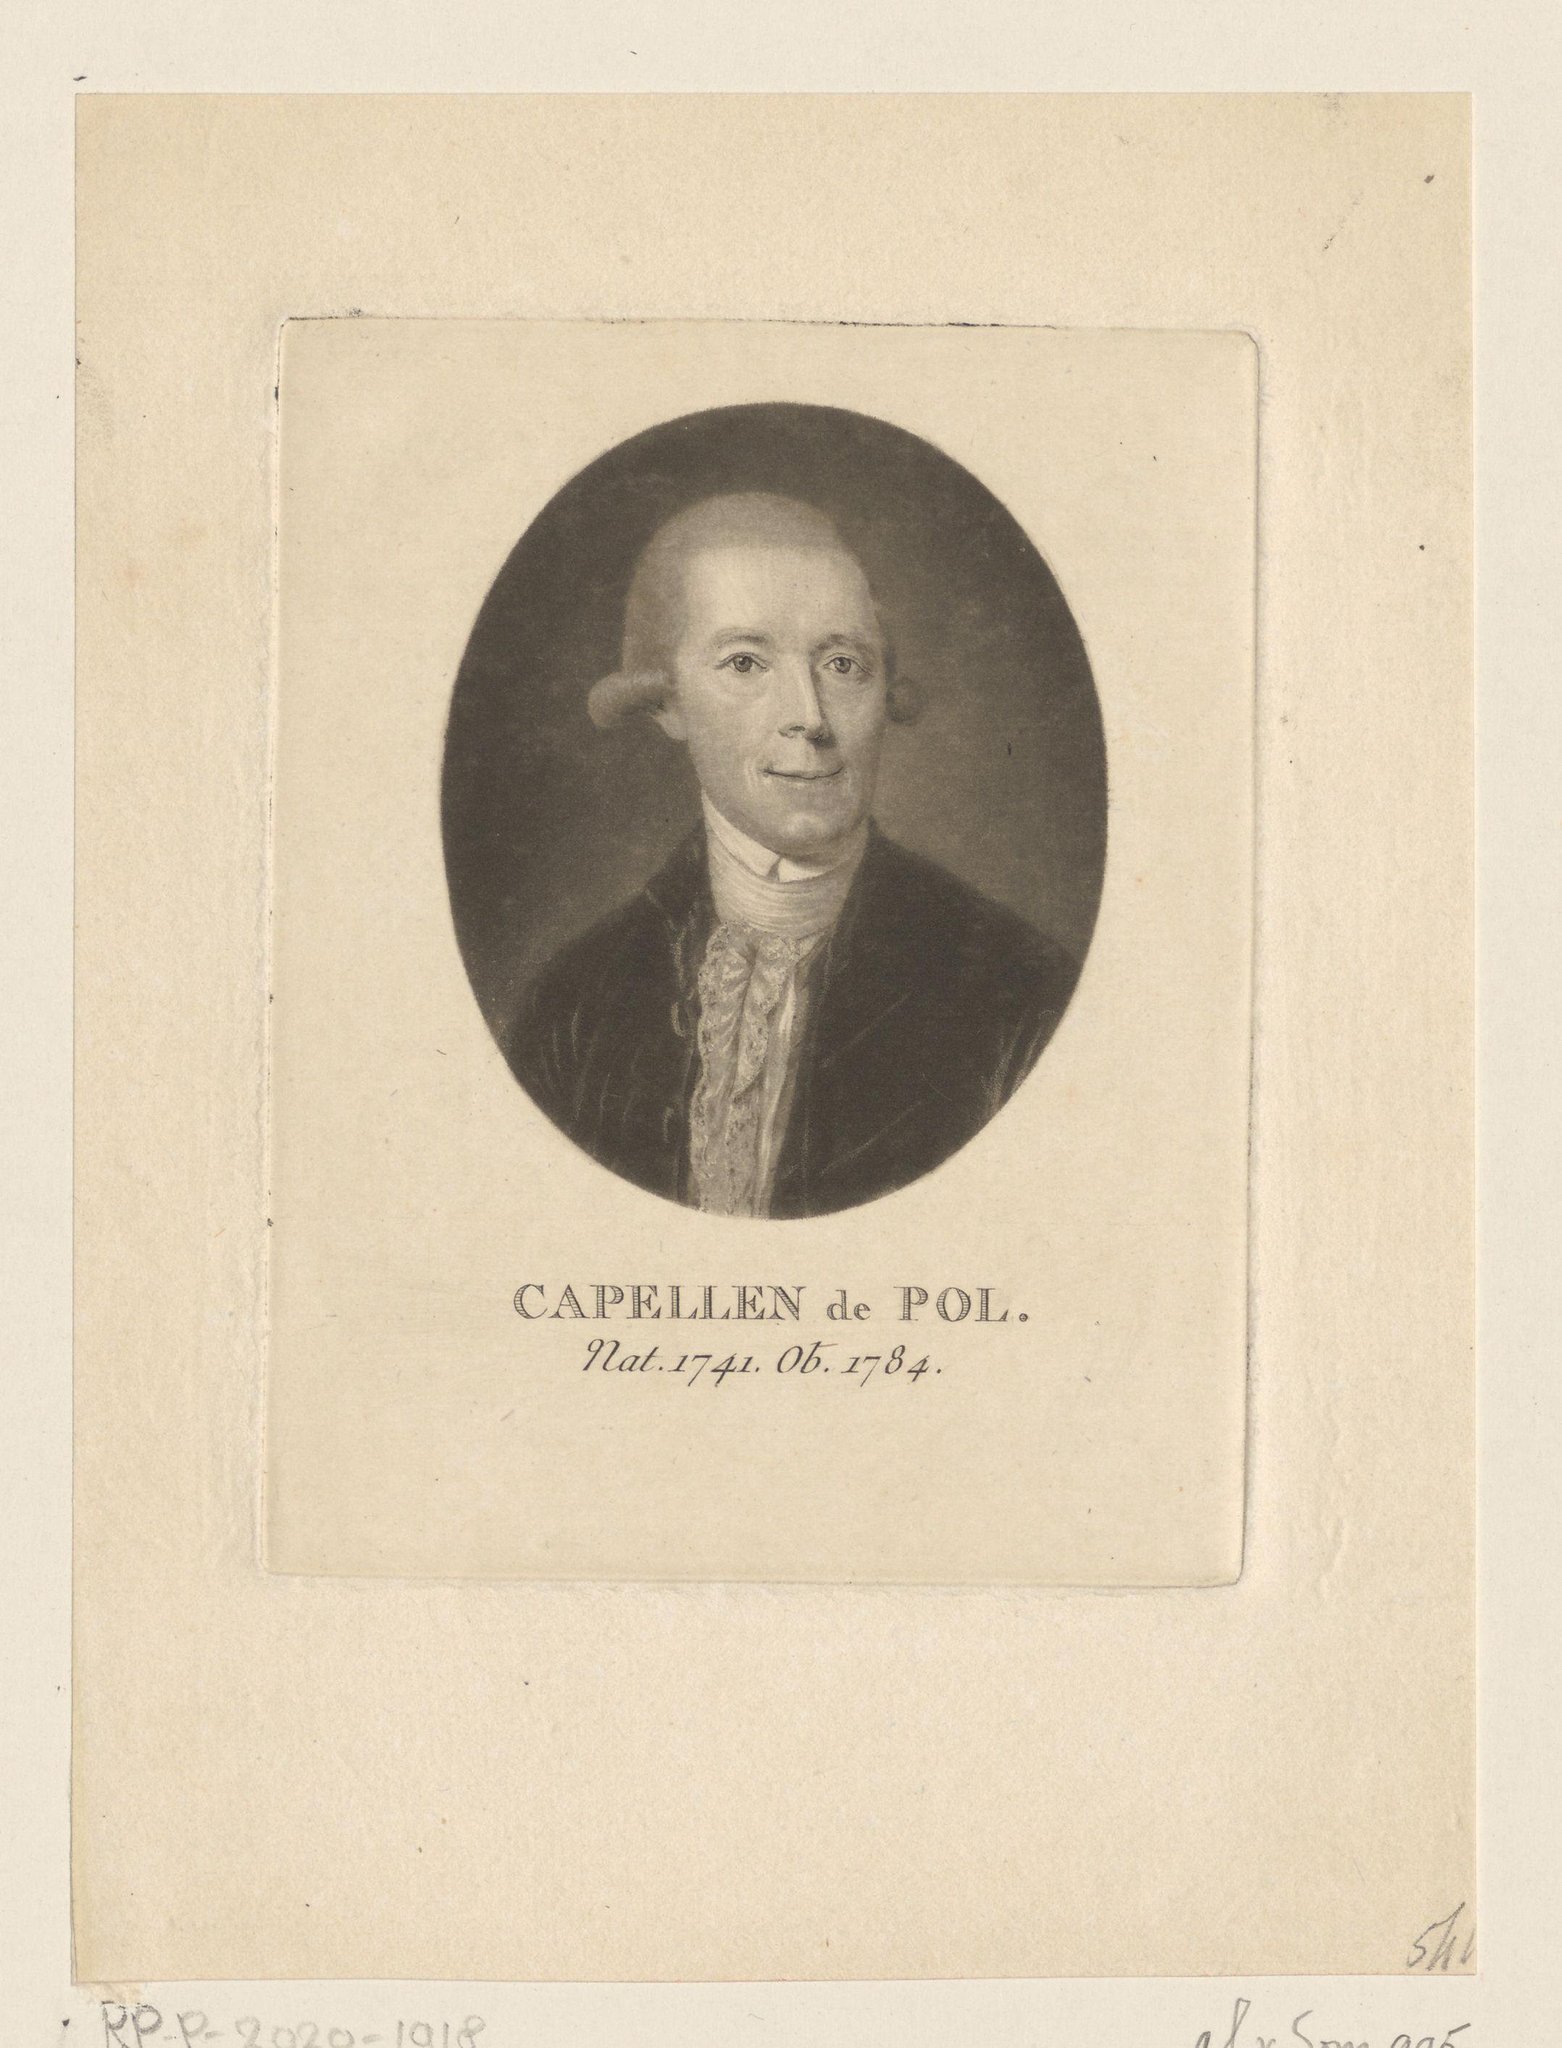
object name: print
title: Portret van Joan Derk van der Capellen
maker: edme quenedey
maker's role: print maker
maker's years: 1756-1830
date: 1784-1830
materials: paper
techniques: mezzotint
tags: politician, historical persons